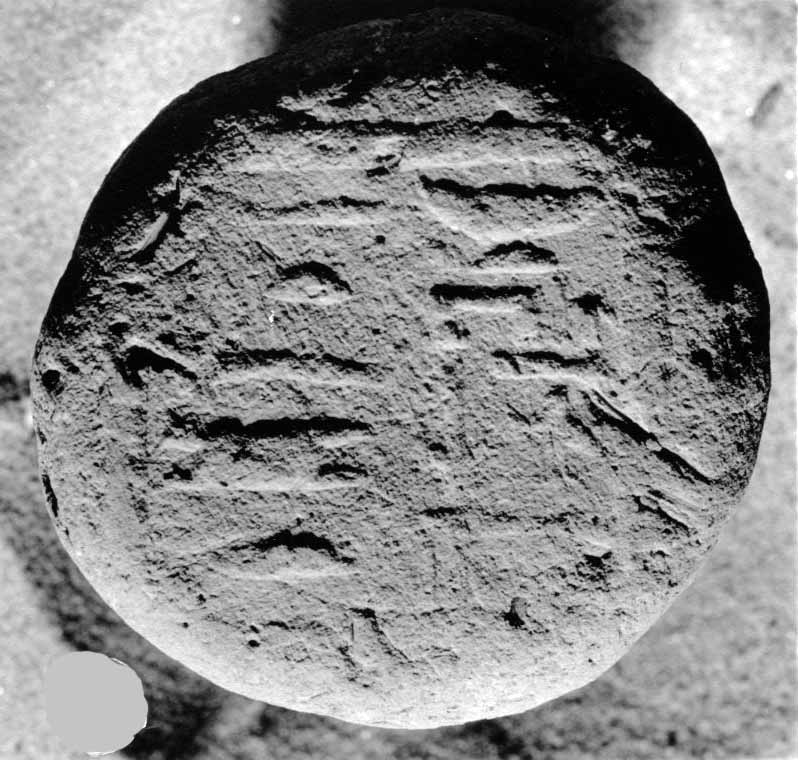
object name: cone, seniseneb, square impression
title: Funerary Cone of a Woman Named Seniseneb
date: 1550-1295 BCE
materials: pottery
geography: egypt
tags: hieroglyphs